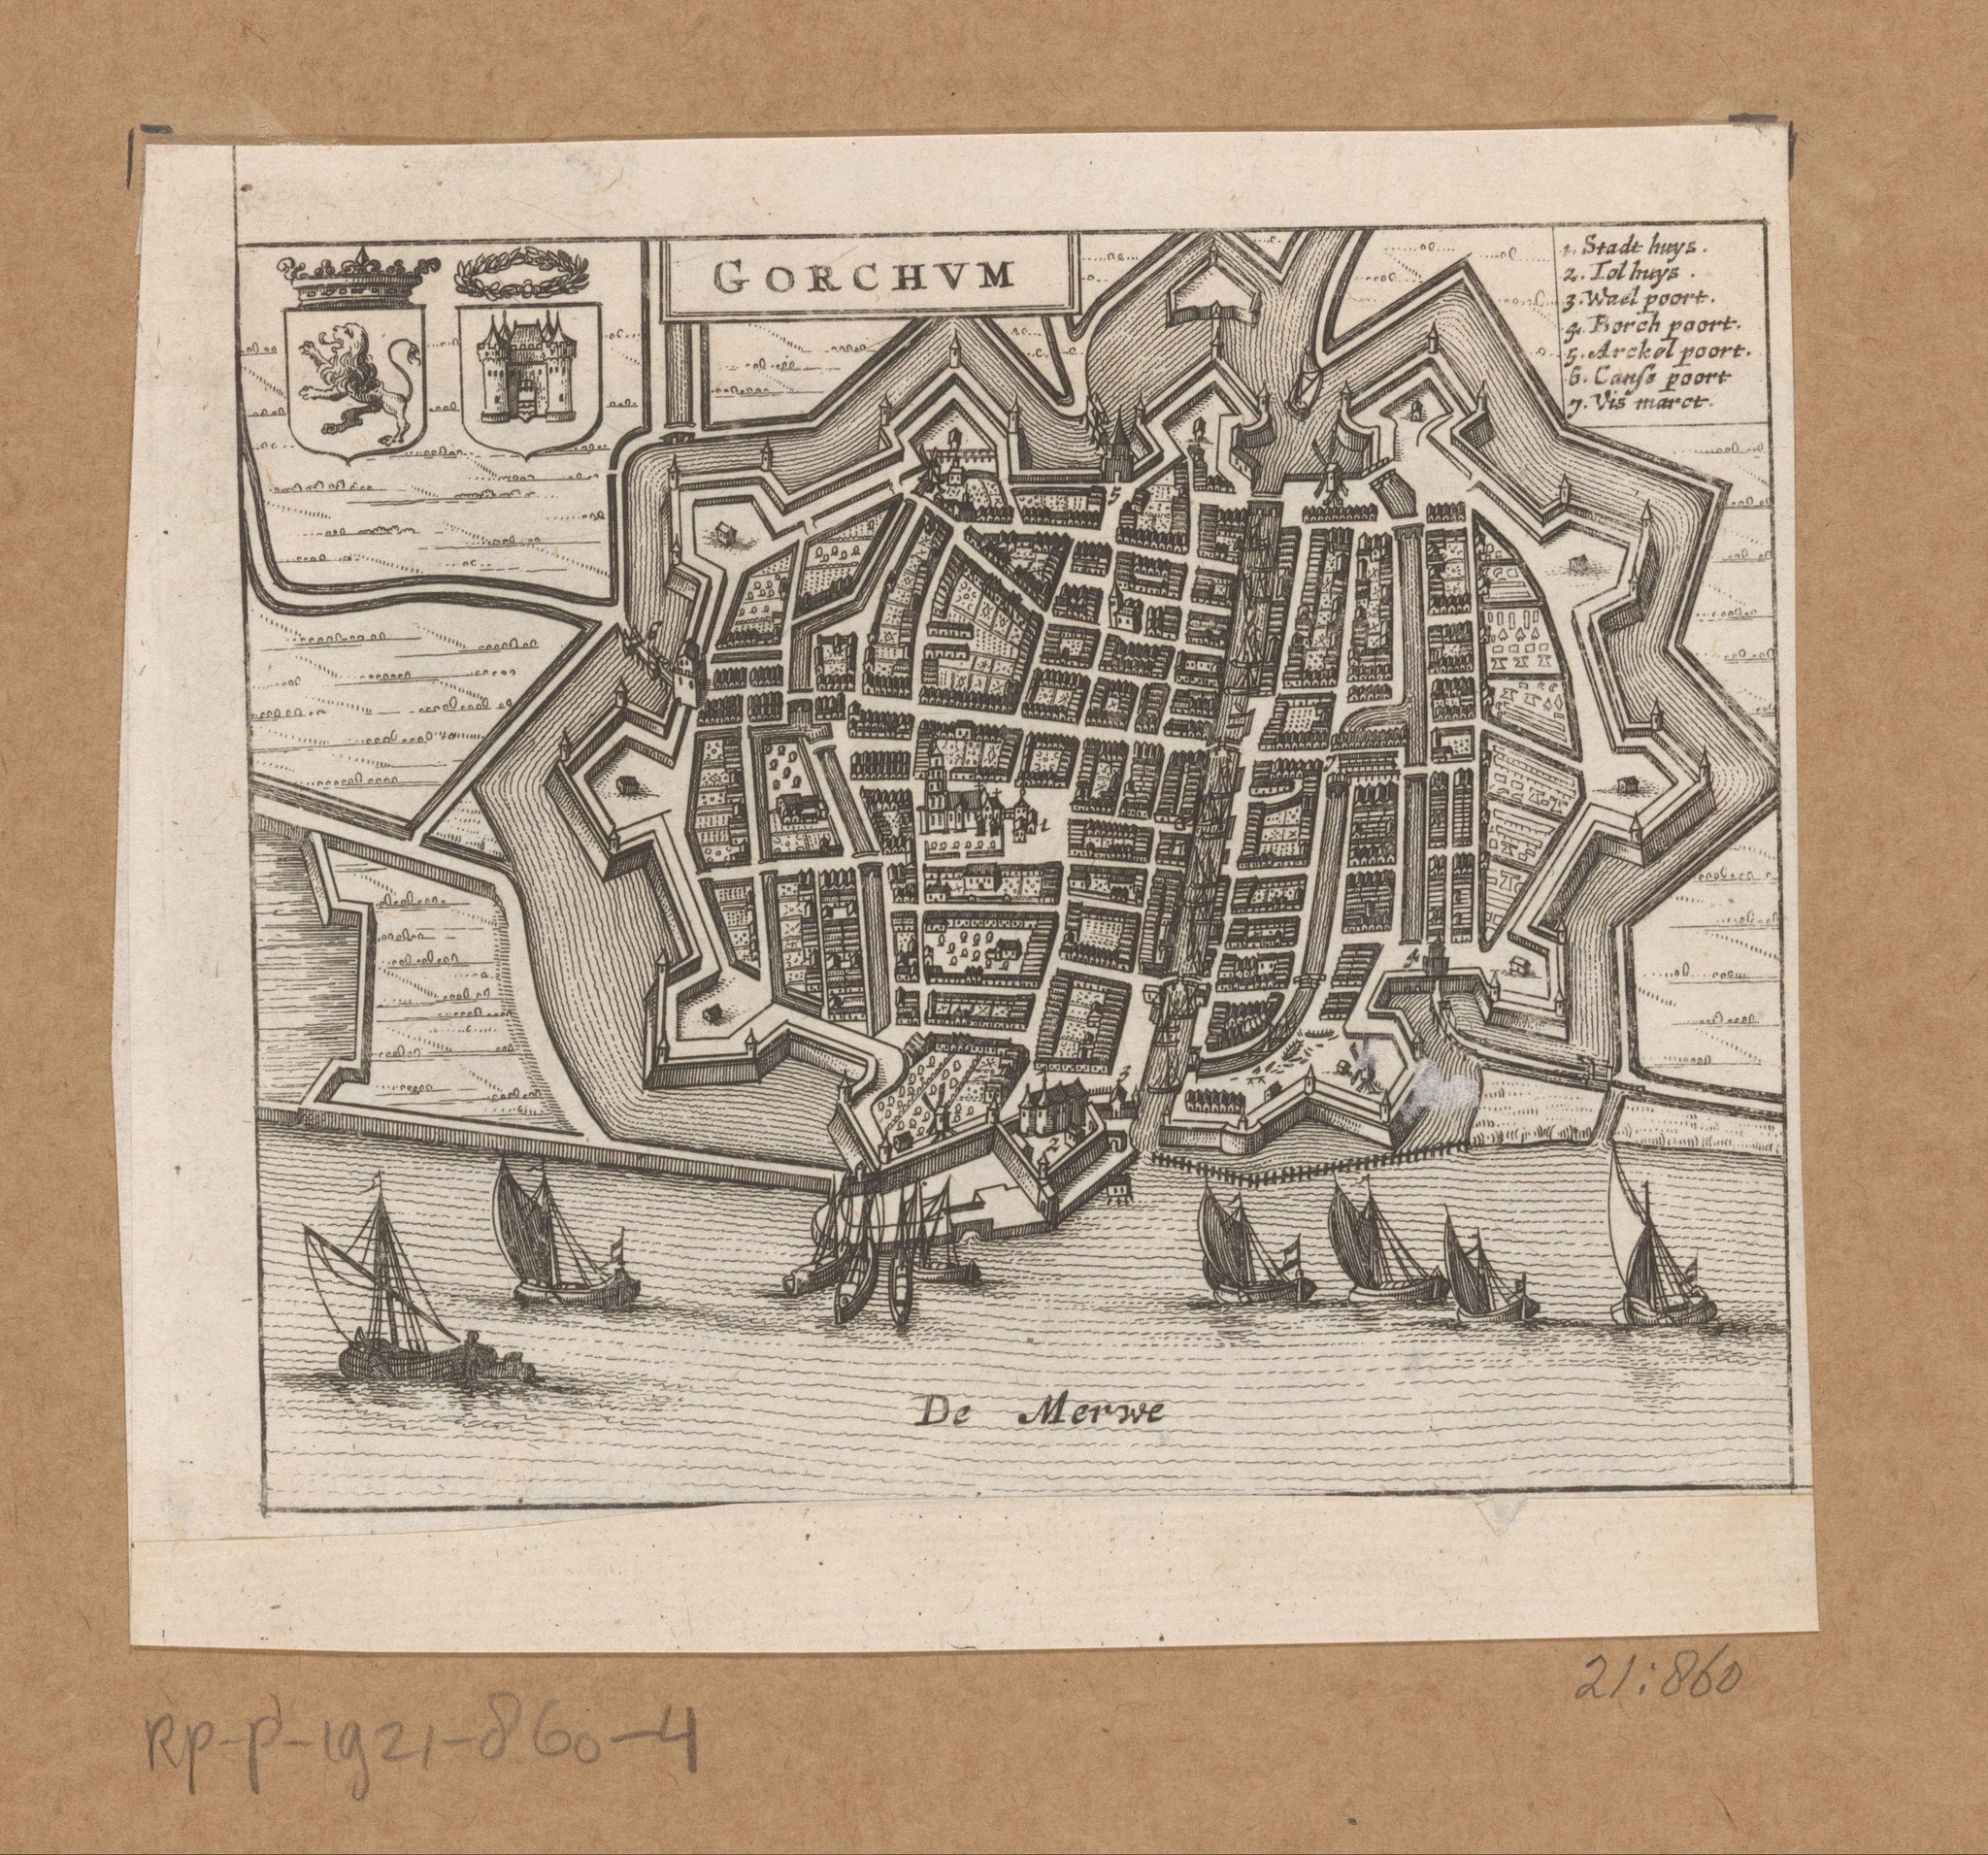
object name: area plan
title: Gorchum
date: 1660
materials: paper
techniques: etching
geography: amsterdam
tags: maps of cities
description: Prent uit: Guicciardini, Lodovico. Belgicae sive inferioris Germaniae Descriptio (...). Amsterdam: Jacob van Meurs, 1660.